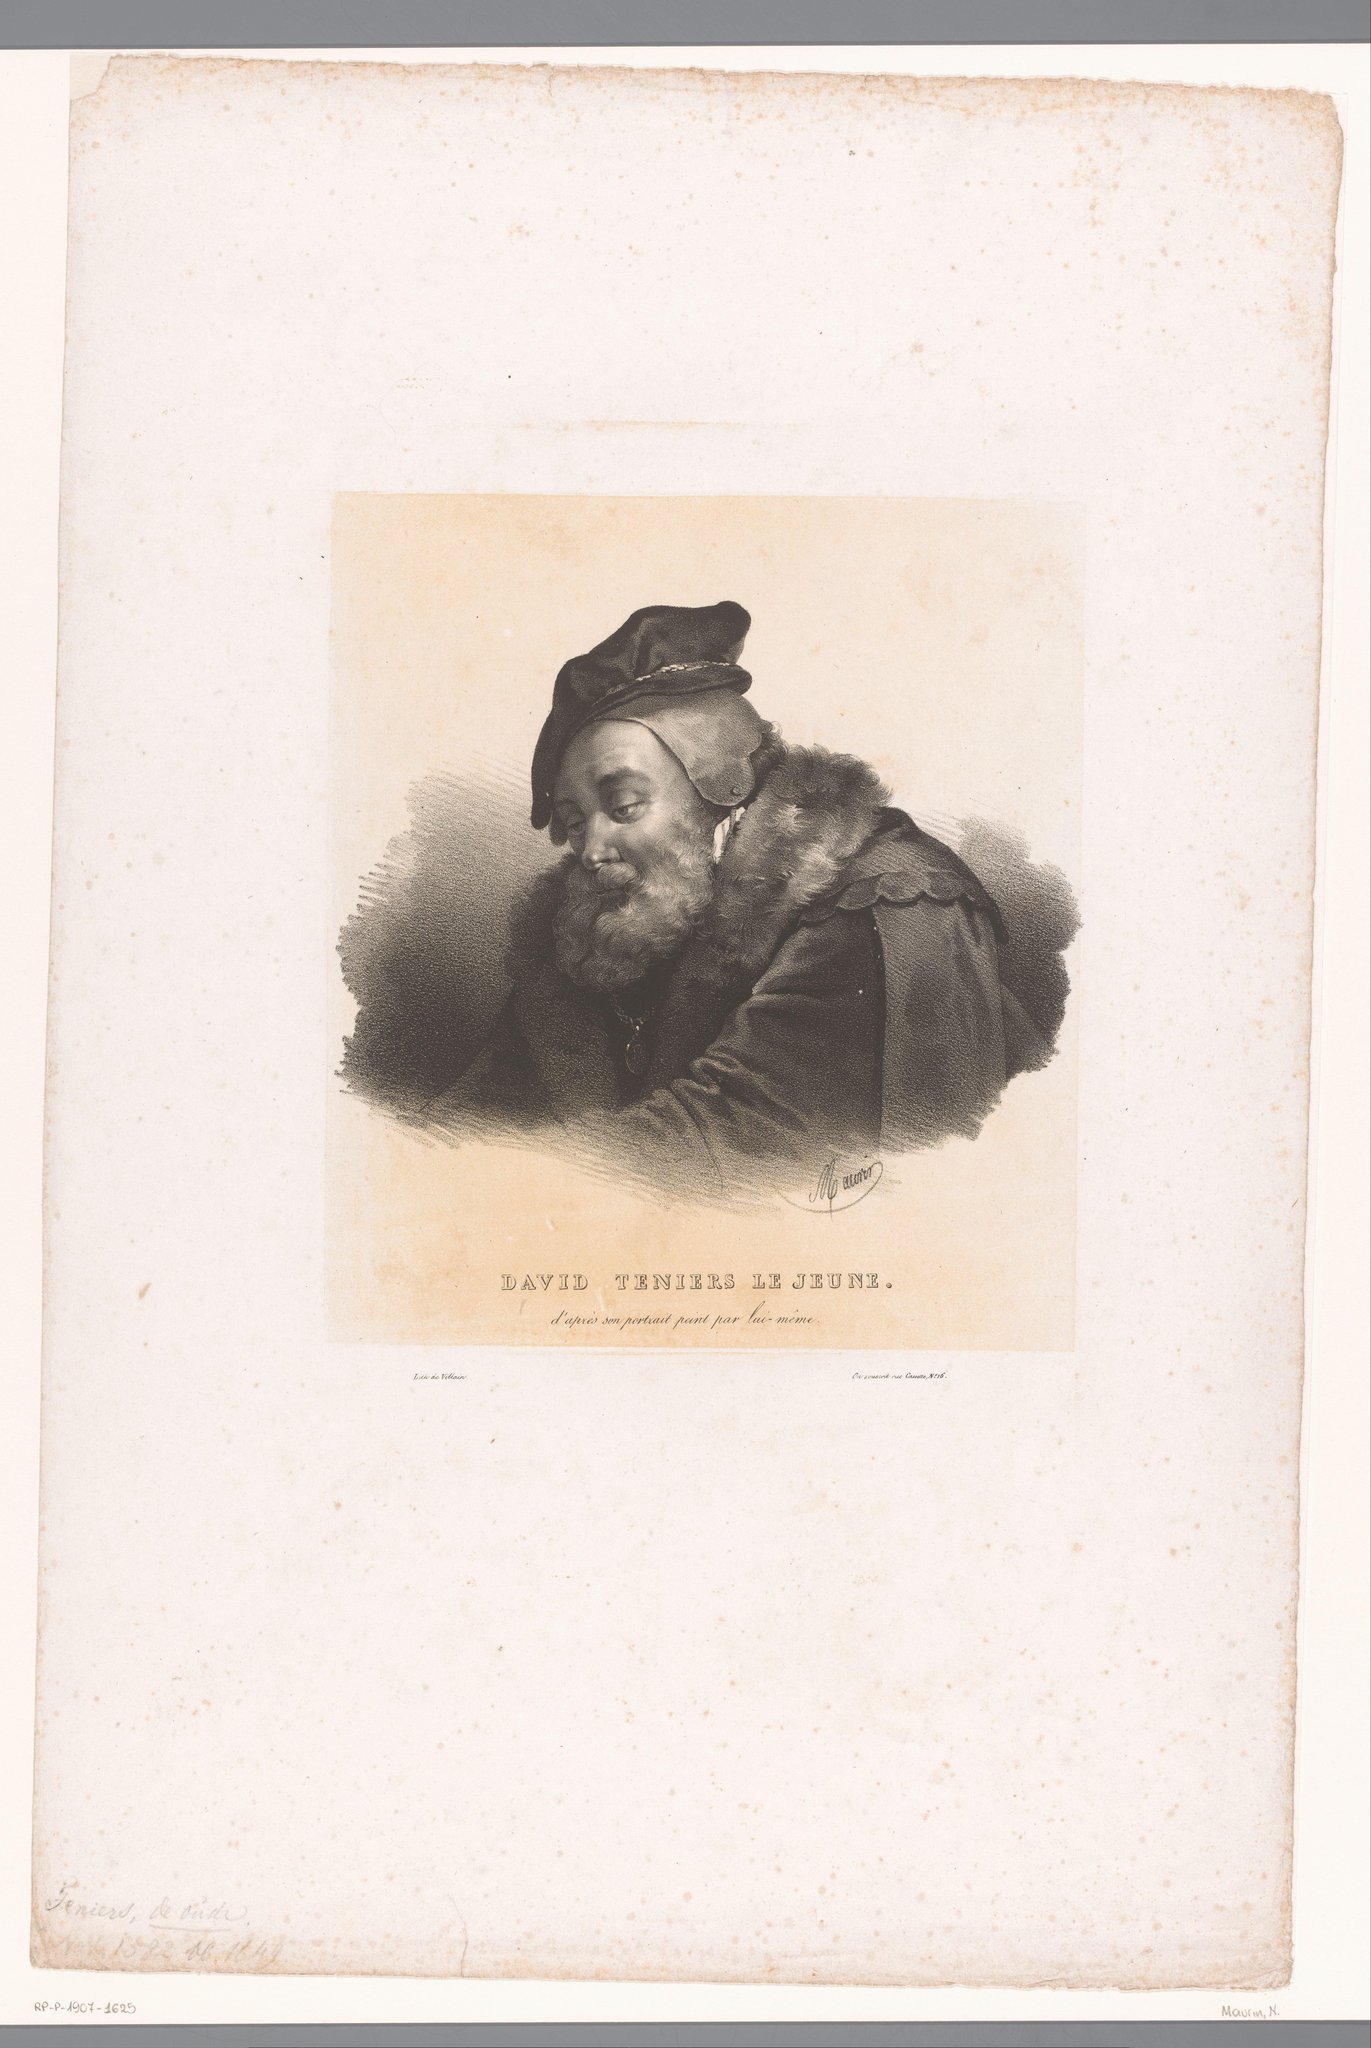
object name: print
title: David Teniers le jeune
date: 1826-1852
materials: paper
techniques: tone lithography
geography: paris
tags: antwerp, painter, print maker, draughtsman, david teniers (ii), historical persons, portrait, self-portrait of painter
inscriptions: collector's mark: Lugt 2228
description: Prent ook gebruikt in: Chabert, Jean Claude. Galerie des peintres ou collection de portraits des peintres les plus célèbres de toutes les écoles. Accompagnée d'une notice sur chacun d'eux, et de copies de dessins originaux / Galerie des peintres ou collection de portraits des peintres les plus célèbres de toutes les écoles. Accompagnée de leur notice historique, de leurs dessins et d'un discours sur les arts. Parijs: Jean Claude Chabert, s.a. [1822-1834]. De samenstelling van tegenwoordig bekende en al dan niet gebonden exemplaren van deze uitgave verschillen. Dit omdat de prenten en bijhorende stukken tekst op inschrijving en waarschijnlijk ook los verkrijgbaar waren.